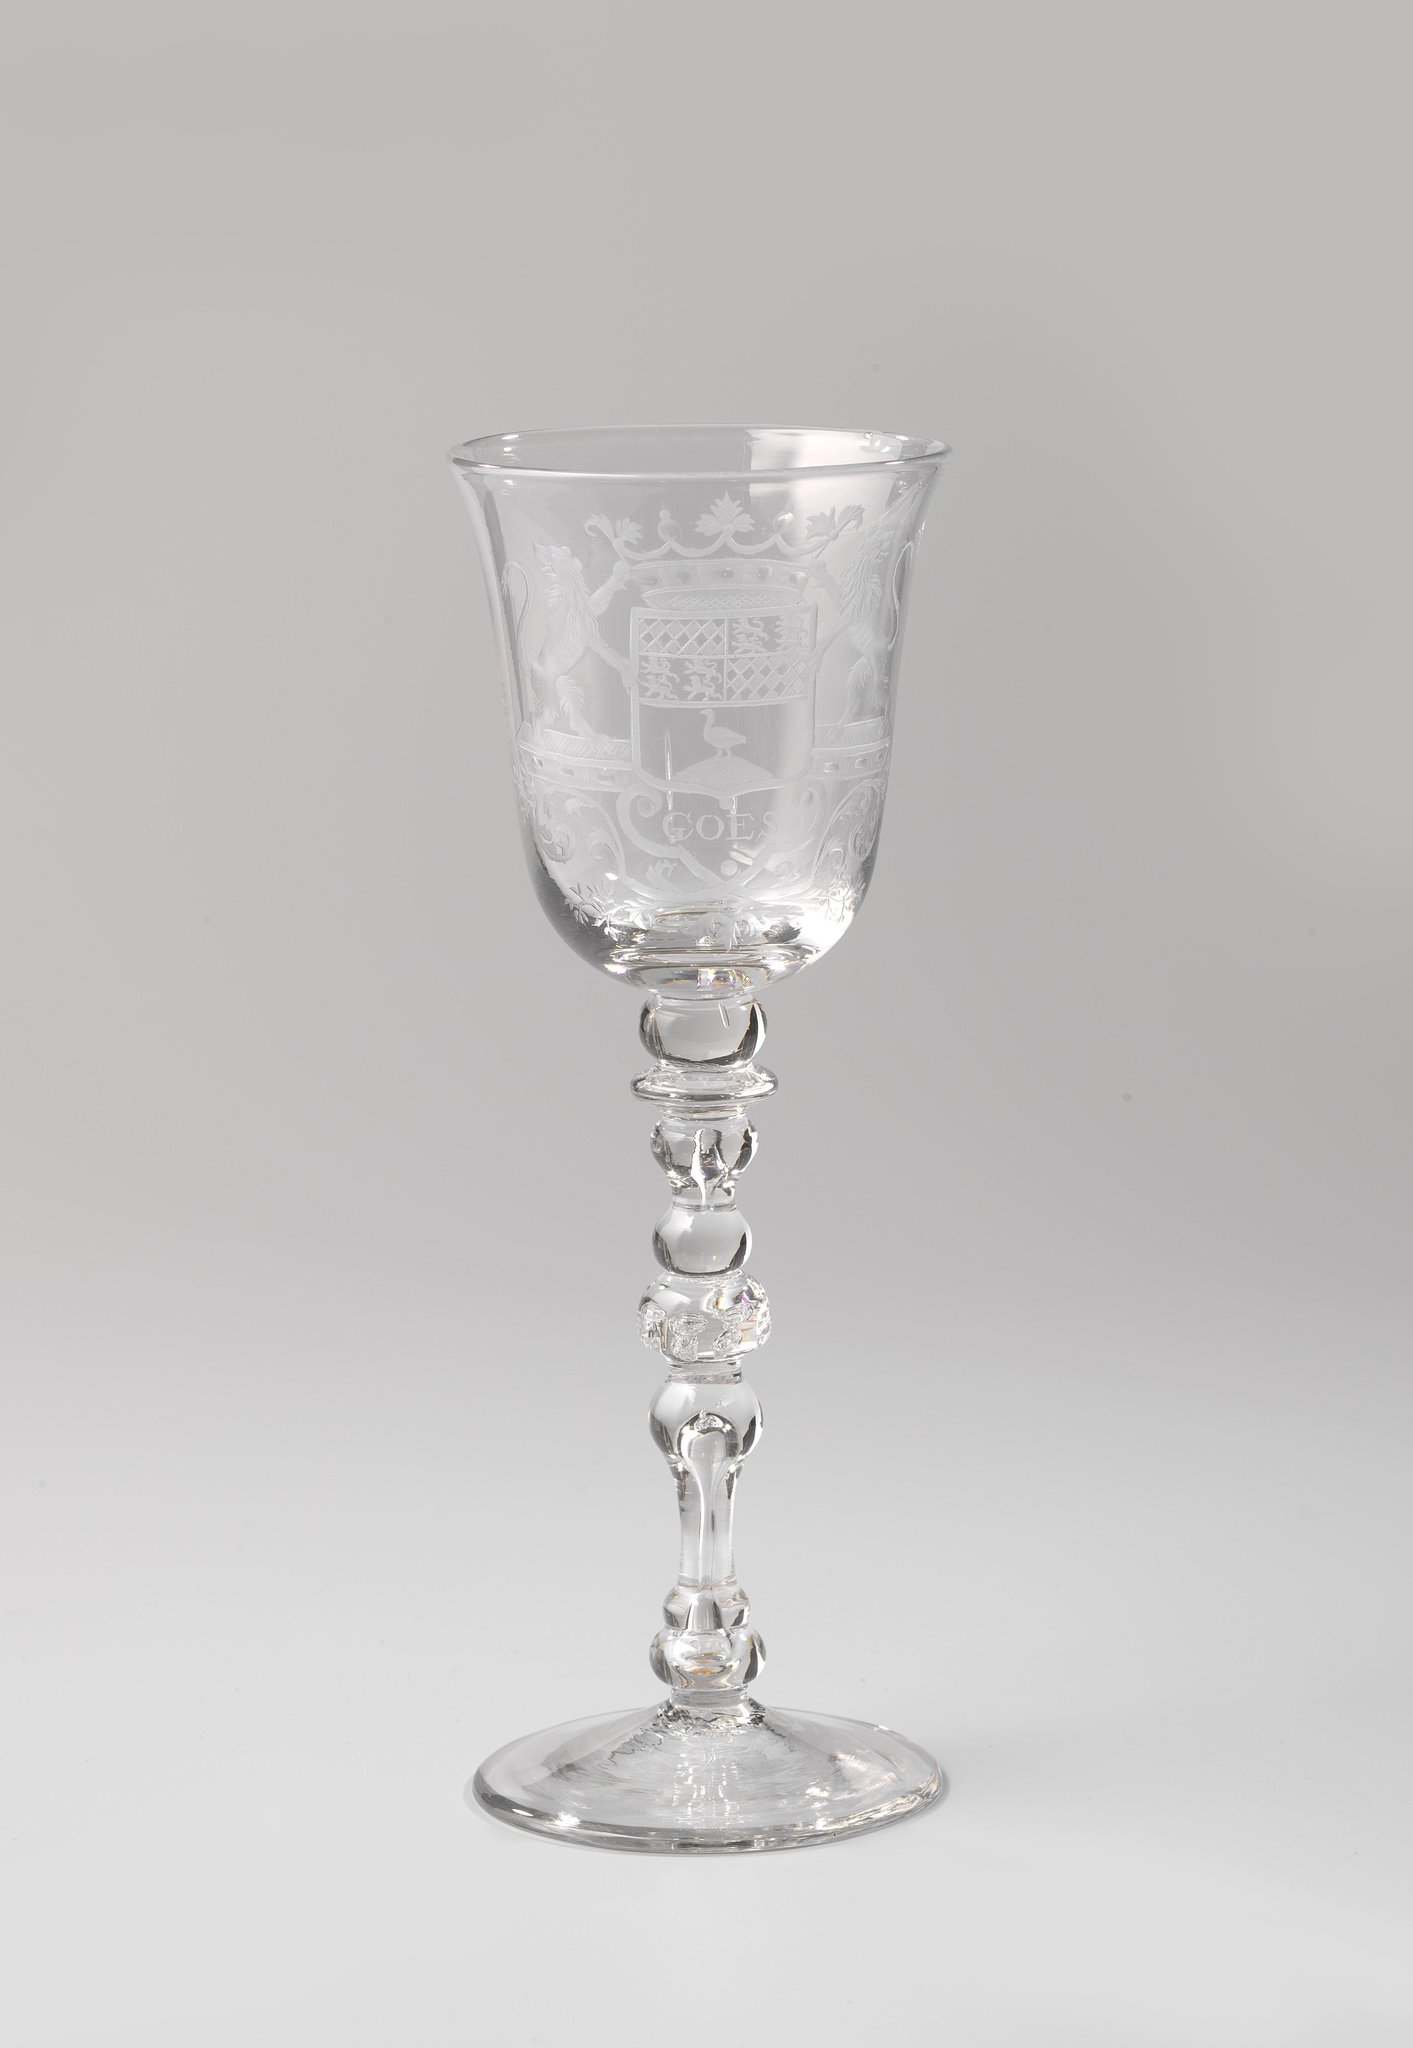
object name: goblet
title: Kelkglas met het wapen van Goes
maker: Anonymous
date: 1725-1750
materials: glass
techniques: glassblowing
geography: northern netherlands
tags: flushing, michiel adriaenszoon de ruyter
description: Coat of Arms of the Zeeland city of Goes.